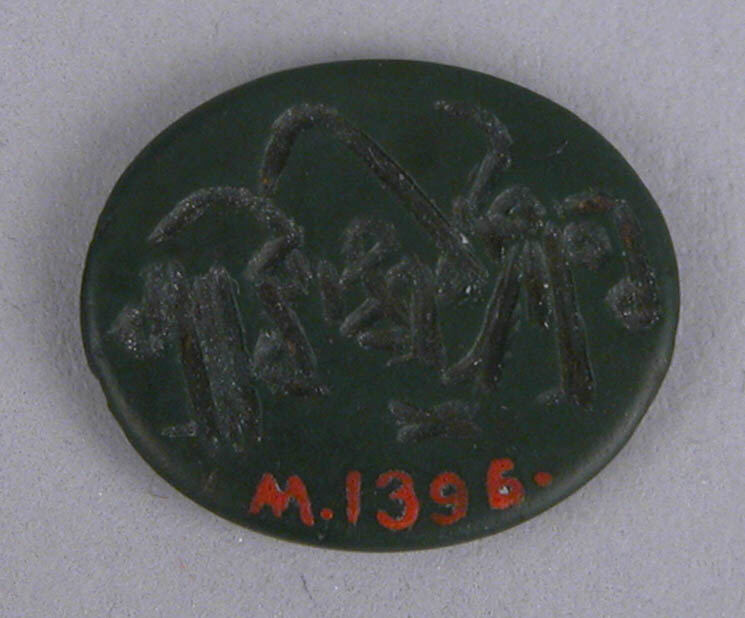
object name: seal ring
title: Seal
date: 1201-1400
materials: jasper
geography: iran